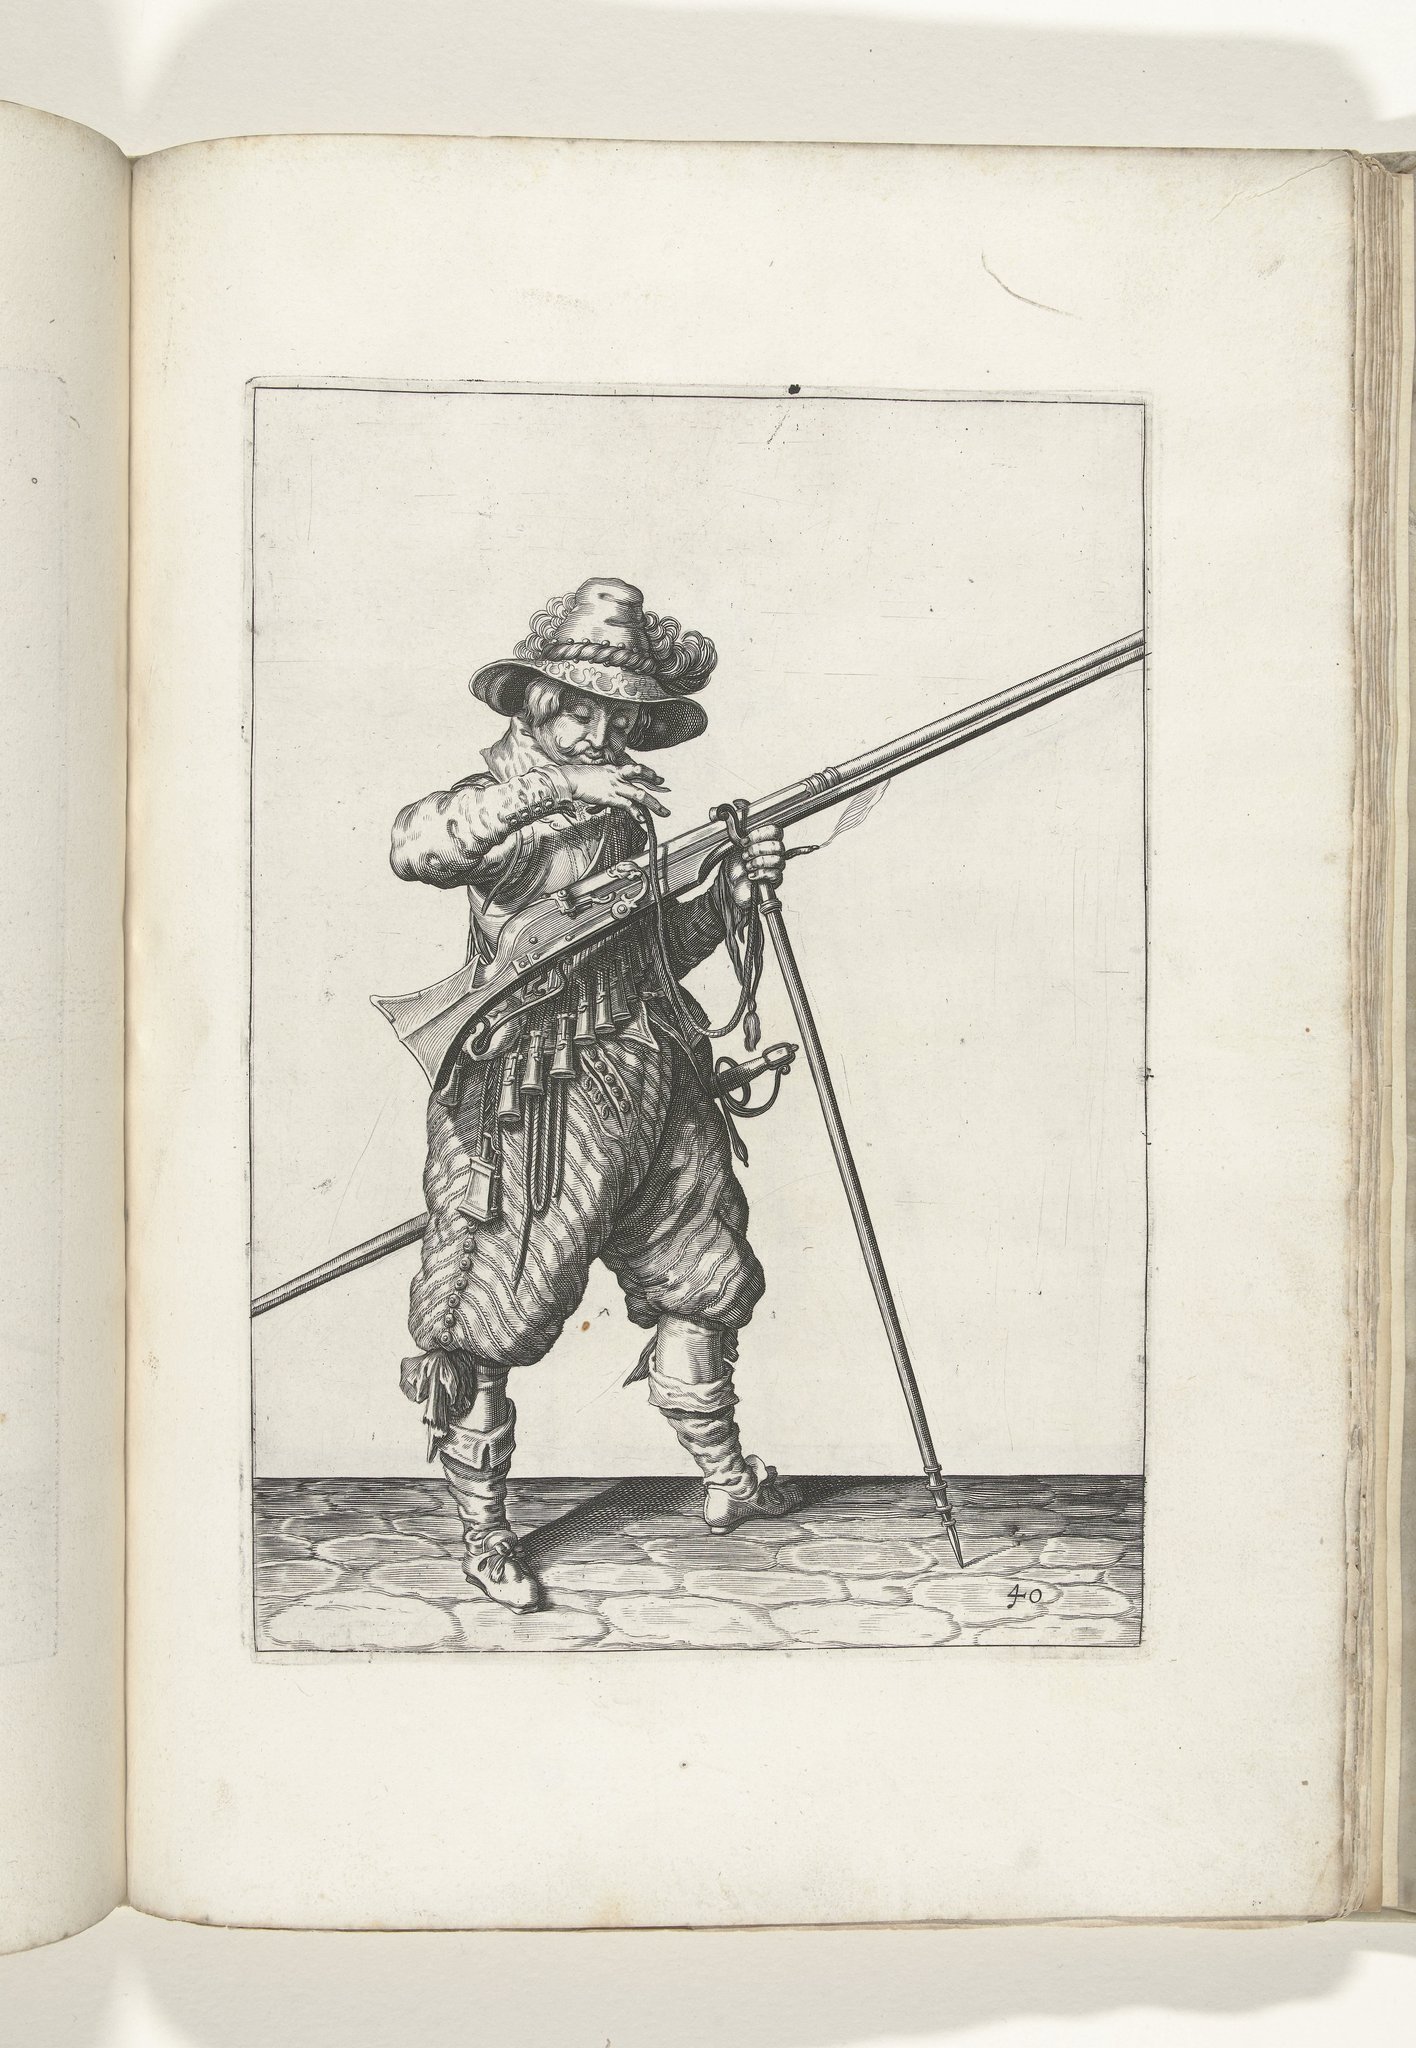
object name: print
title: Soldaat op wacht met een musket die zijn lont naar zijn mond brengt om hem schoon te blazen (nr. 40), ca. 1600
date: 1597-1607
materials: paper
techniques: engraving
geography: the hague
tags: maurice (prince of orange), handling of weapons ~ military training, weapons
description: Een soldaat op wacht, ten voeten uit, naar rechts, die een musket (een bepaald type vuurwapen) met zijn linkerhand vasthoudt bij de vork van het furket (musketvork) waar de loop op steunt (nr. 40), ca. 1600. Met zijn rechterhand brengt hij een brandende lont naar zijn mond om hem schoon te blazen. Plaat 40 in de instructies voor het hanteren van het musket: Corte onderrechtinghe op de figuerliicke afbeeldinghe, soo veel aengaet het recht ghebruyck vant Musquet. Onderdeel van de illustraties in: J. de Gheyn, Wapenhandelinghe van Roers Musquetten ende spiessen, 's-Gravenhage, 1607. Krijgswezen rond 1600.